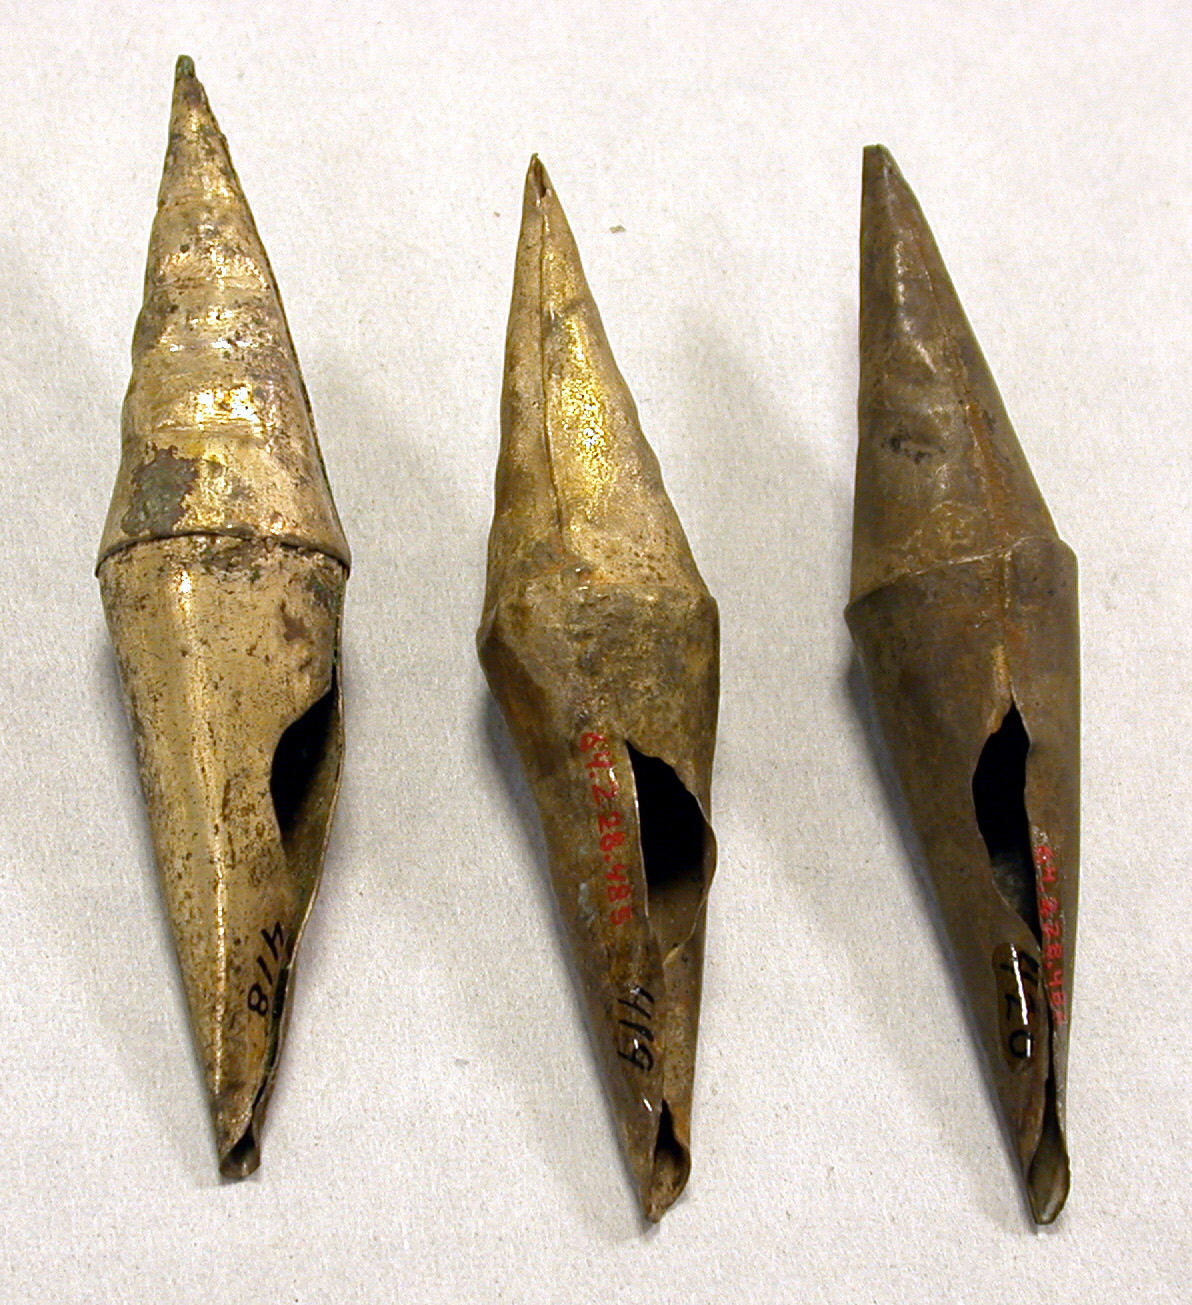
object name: ornament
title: Hammered Silver Cone Ornament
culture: peruvian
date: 701-1566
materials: gilt, silver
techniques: hammering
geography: peru